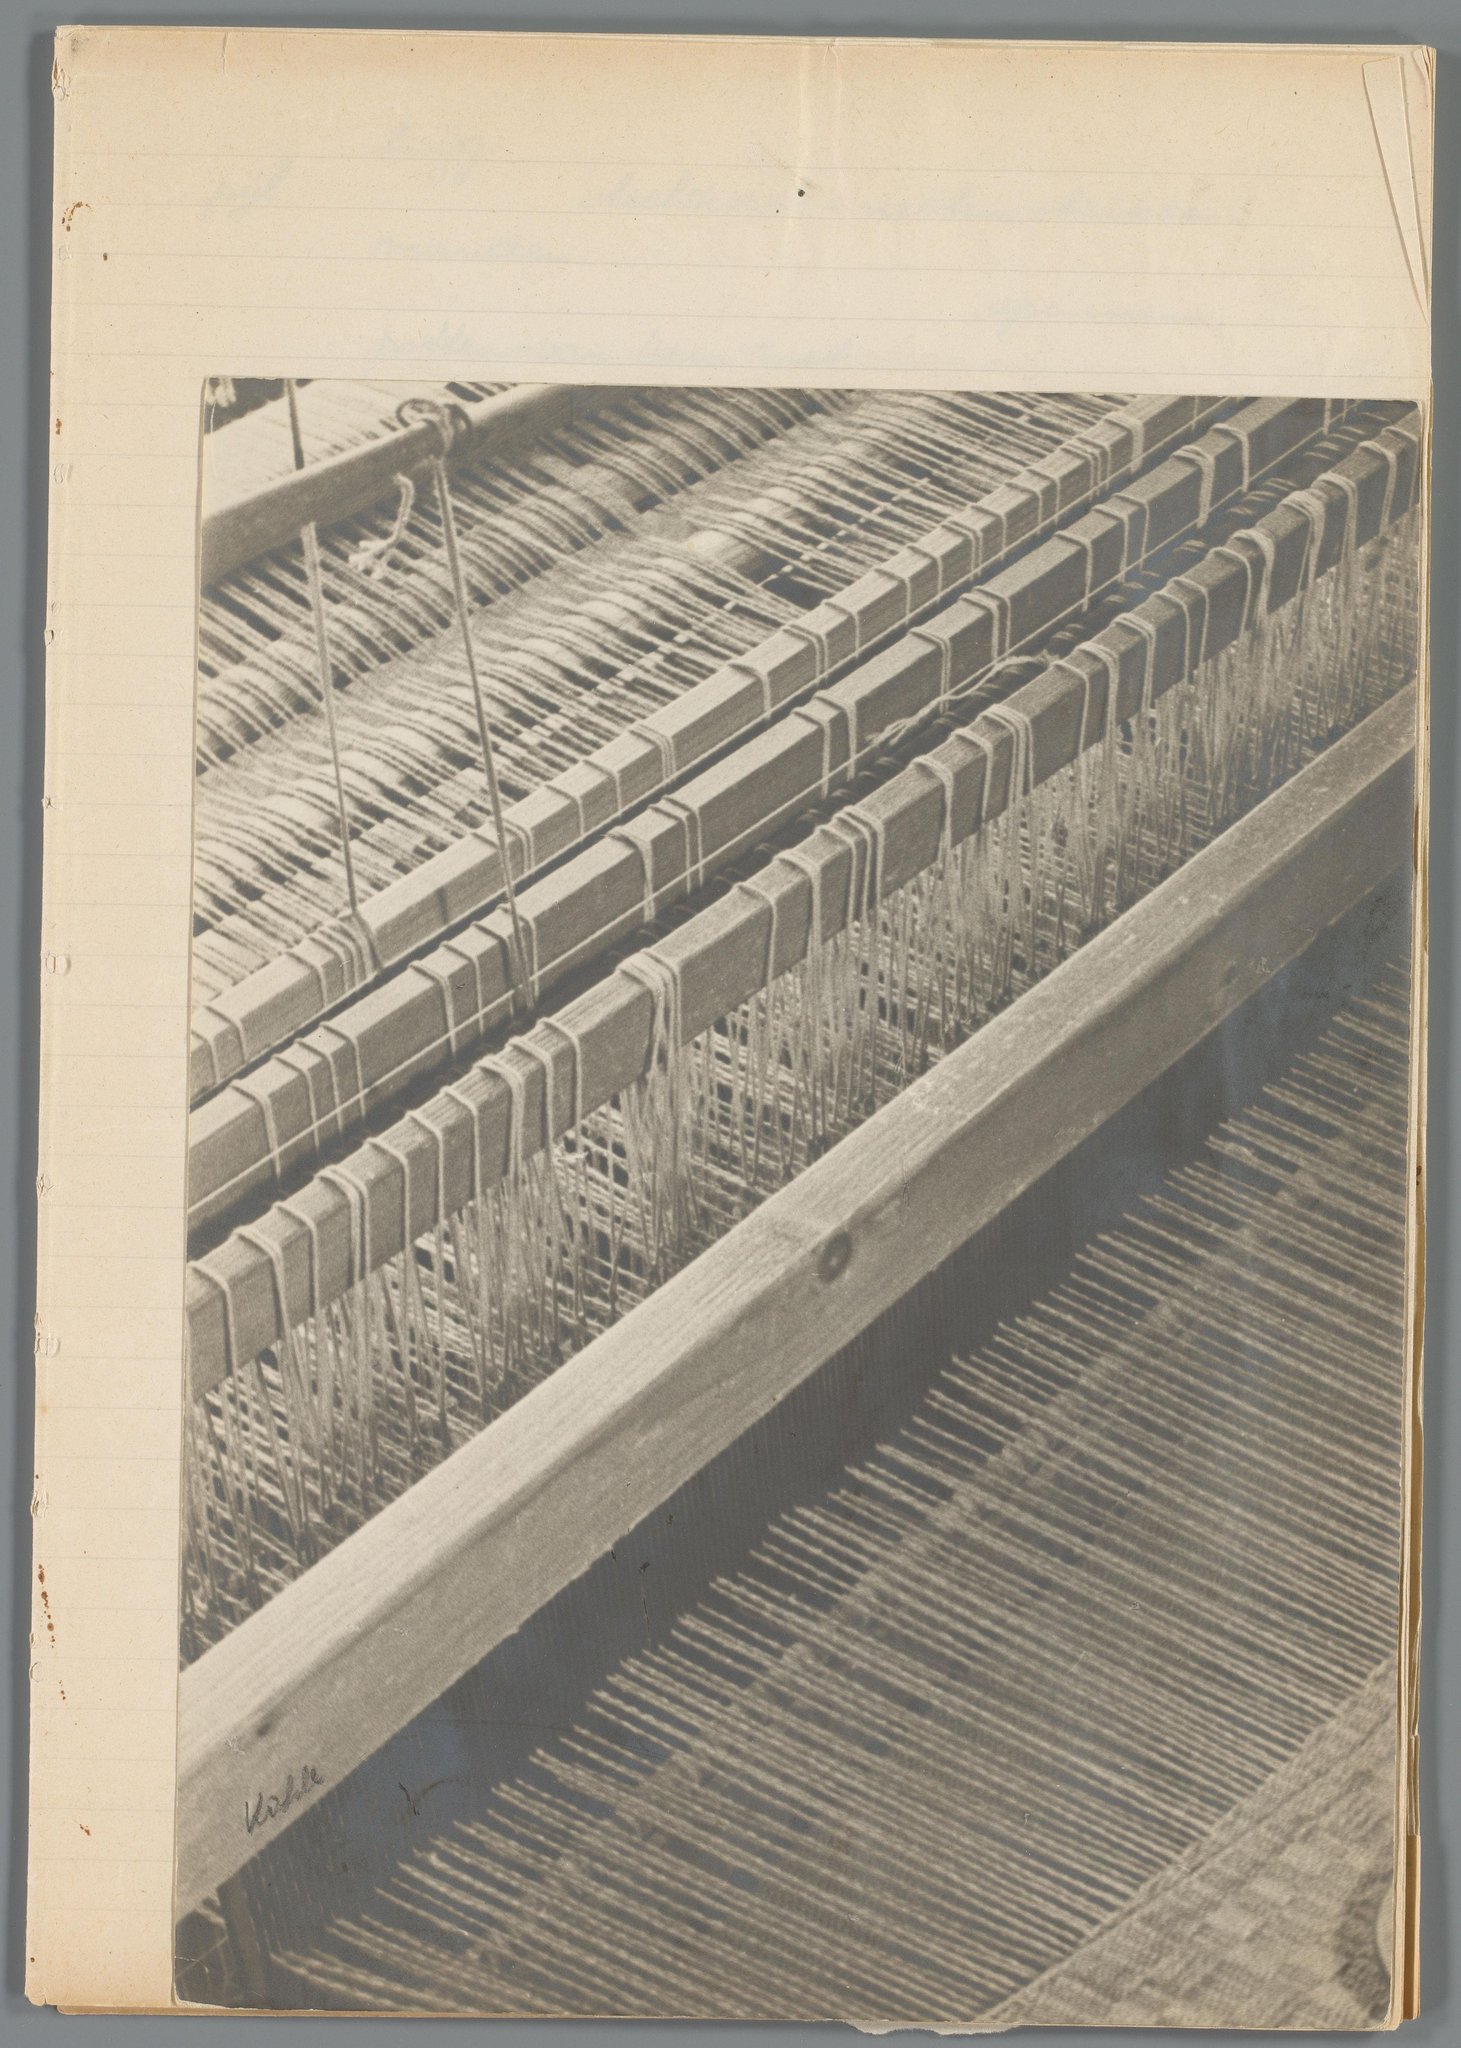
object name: photomechanical print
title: Eindexamenwerkstuk van Jet van Gelder voor het IVKNO, afdeling textiel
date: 1950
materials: paper, ink, pencil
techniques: photograph, gelatin silver print, pen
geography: amsterdam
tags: reel of yarn, weaving-loom, weaving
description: Eindexamenwerkstuk van H.A. (Jet) van Gelder voor het IVKNO, afdeling textiel, met een foto van een weefgetouw door Kurt Kahle op de voorkant. Bij de tekst zijn nog enkele fotomechanische afdrukken gevoegd.